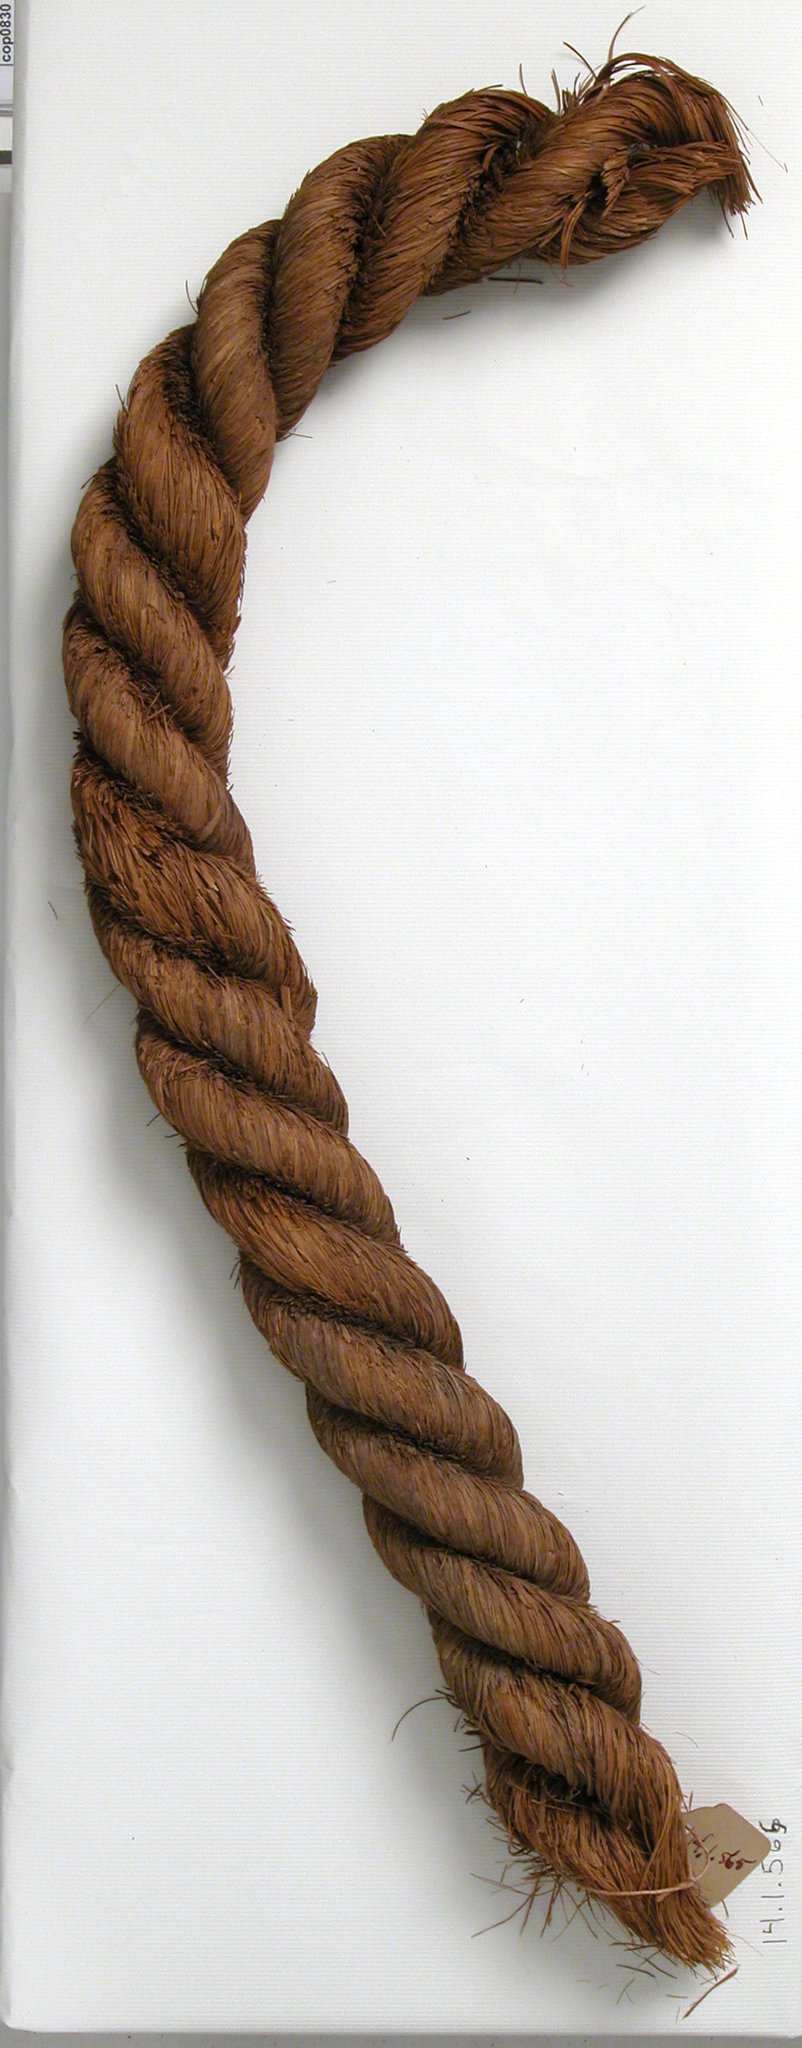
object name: fragment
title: Rope Fragment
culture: coptic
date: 580-640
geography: egypt